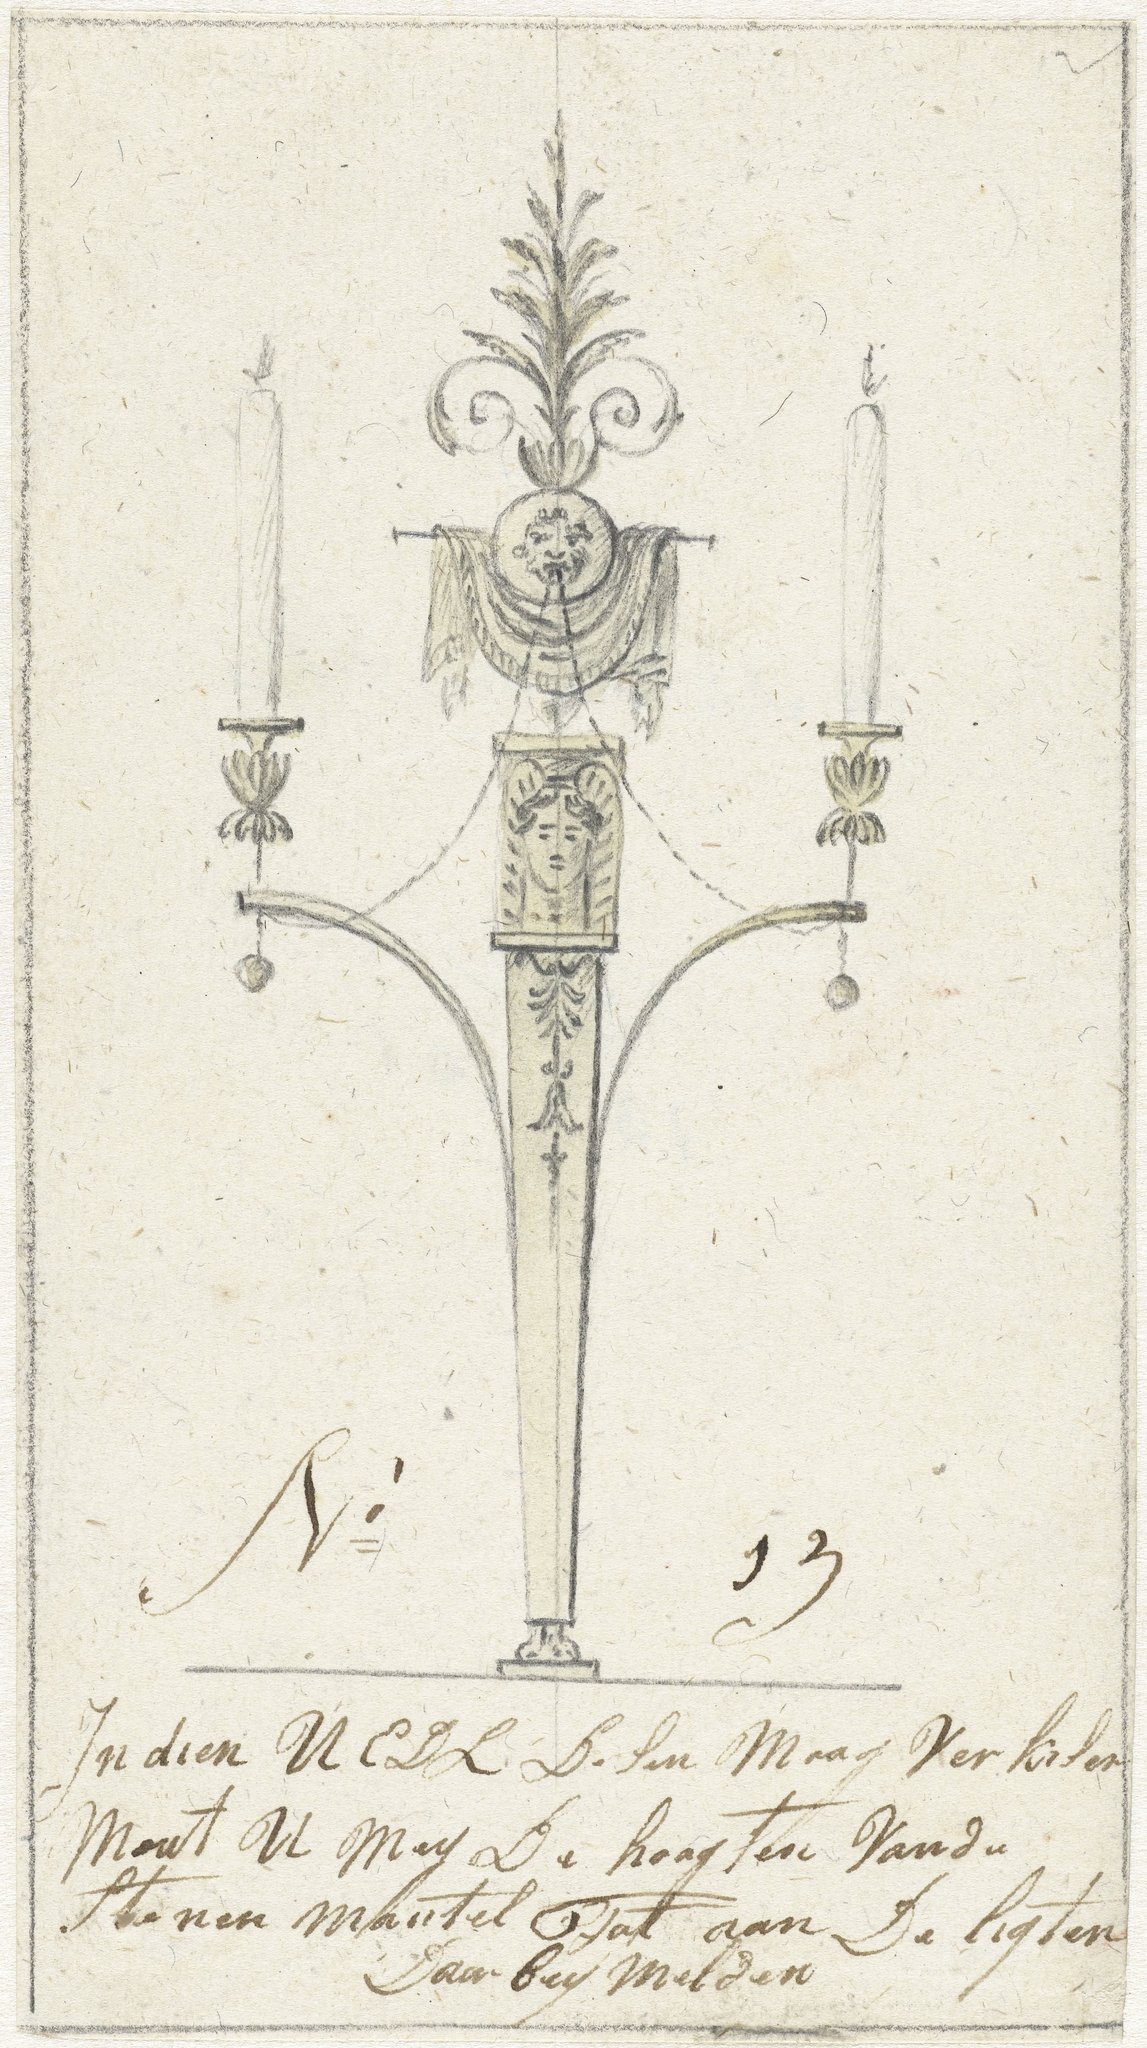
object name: drawing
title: Ontwerp voor een kandelaar (No. 13)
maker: abraham meertens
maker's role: draughtsman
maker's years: 1757-1823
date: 1767-1823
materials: paper, pencil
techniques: brush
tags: sconce, wall lamp